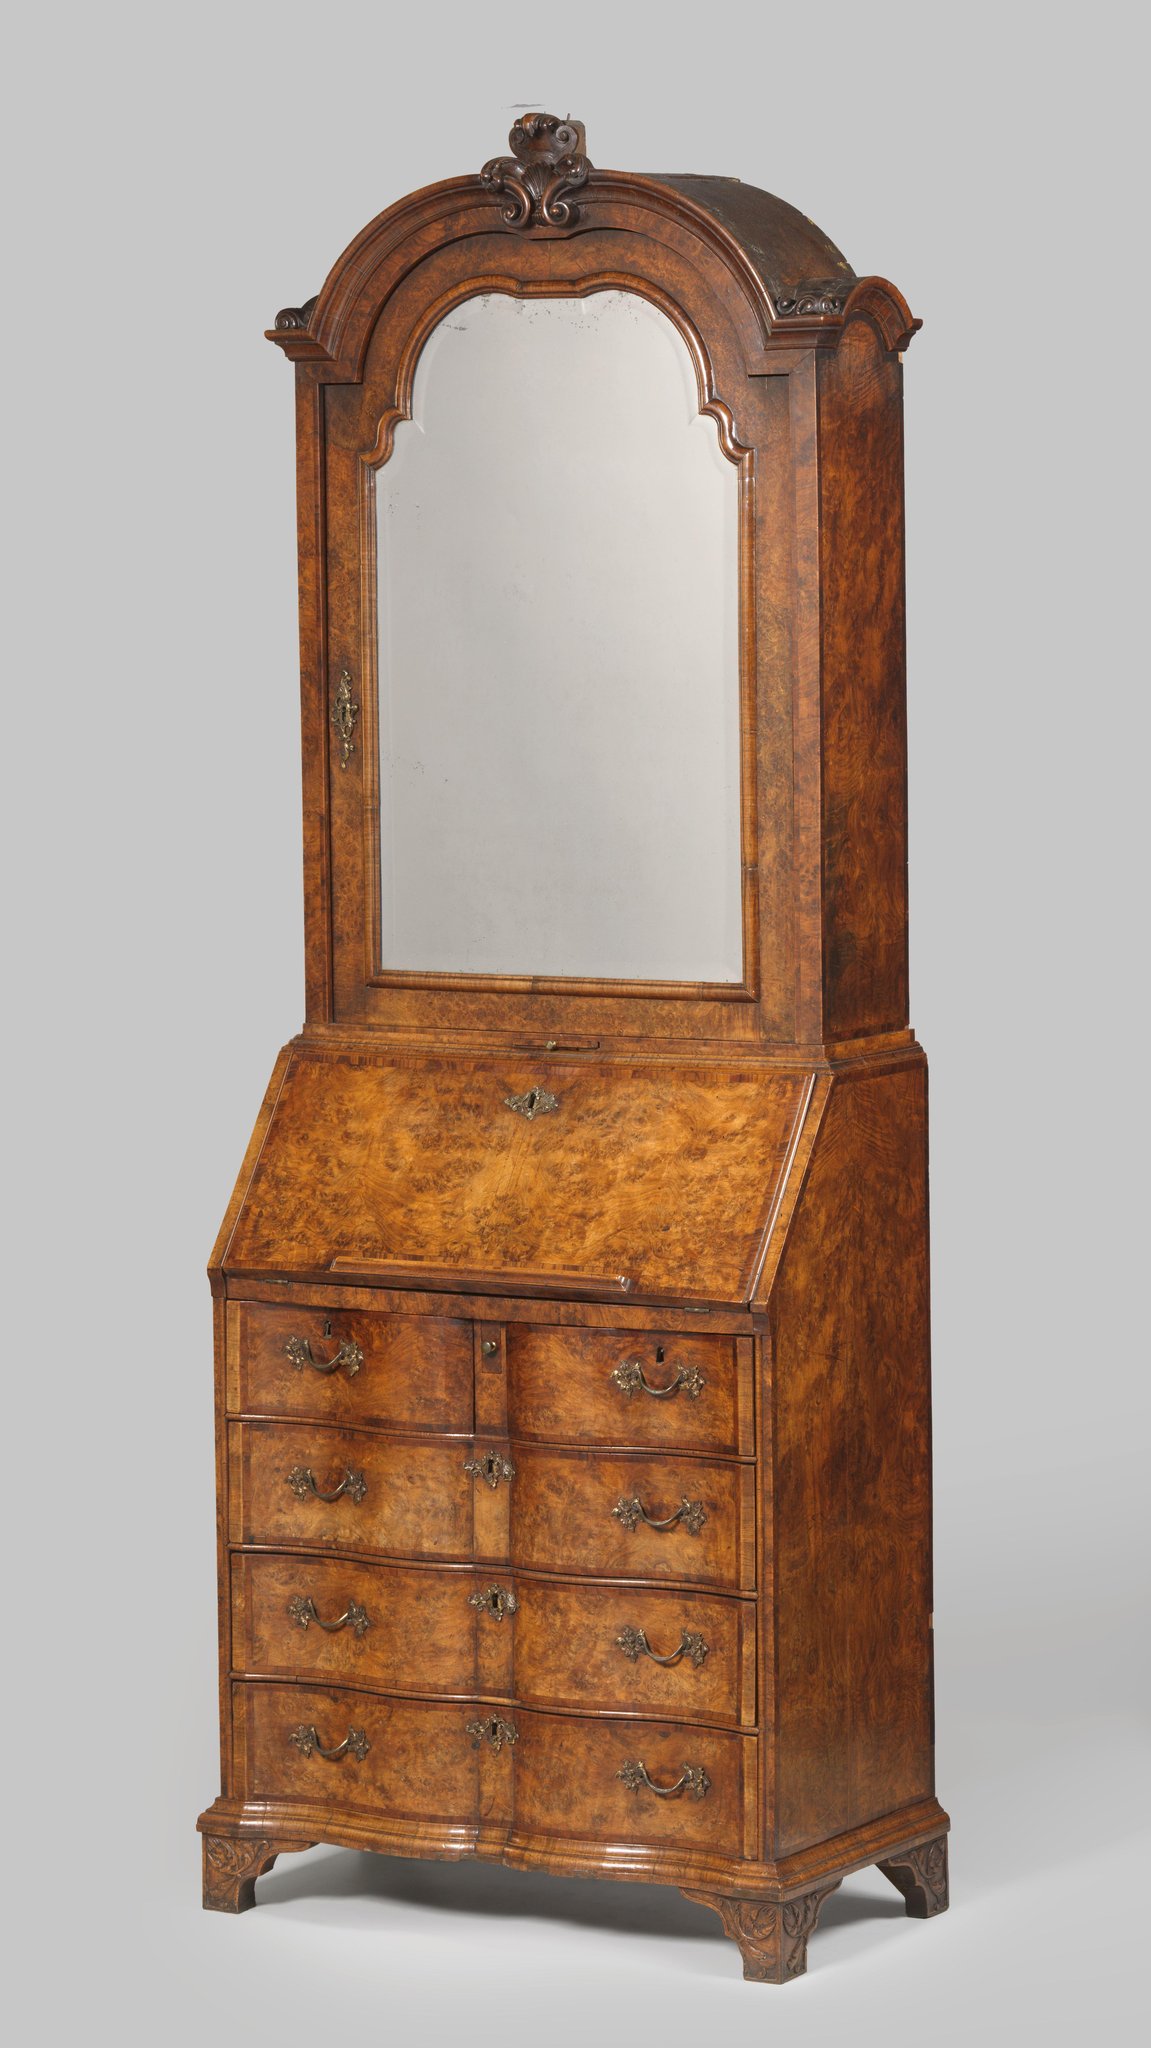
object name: schrijfkabinet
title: Schrijfkabinet met spiegel in bovendeur; front onderkast met laden is accoladevormig uitgeschulpt.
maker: Anonymous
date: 1750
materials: amalgam, copper, glass, wood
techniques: gilding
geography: northern netherlands